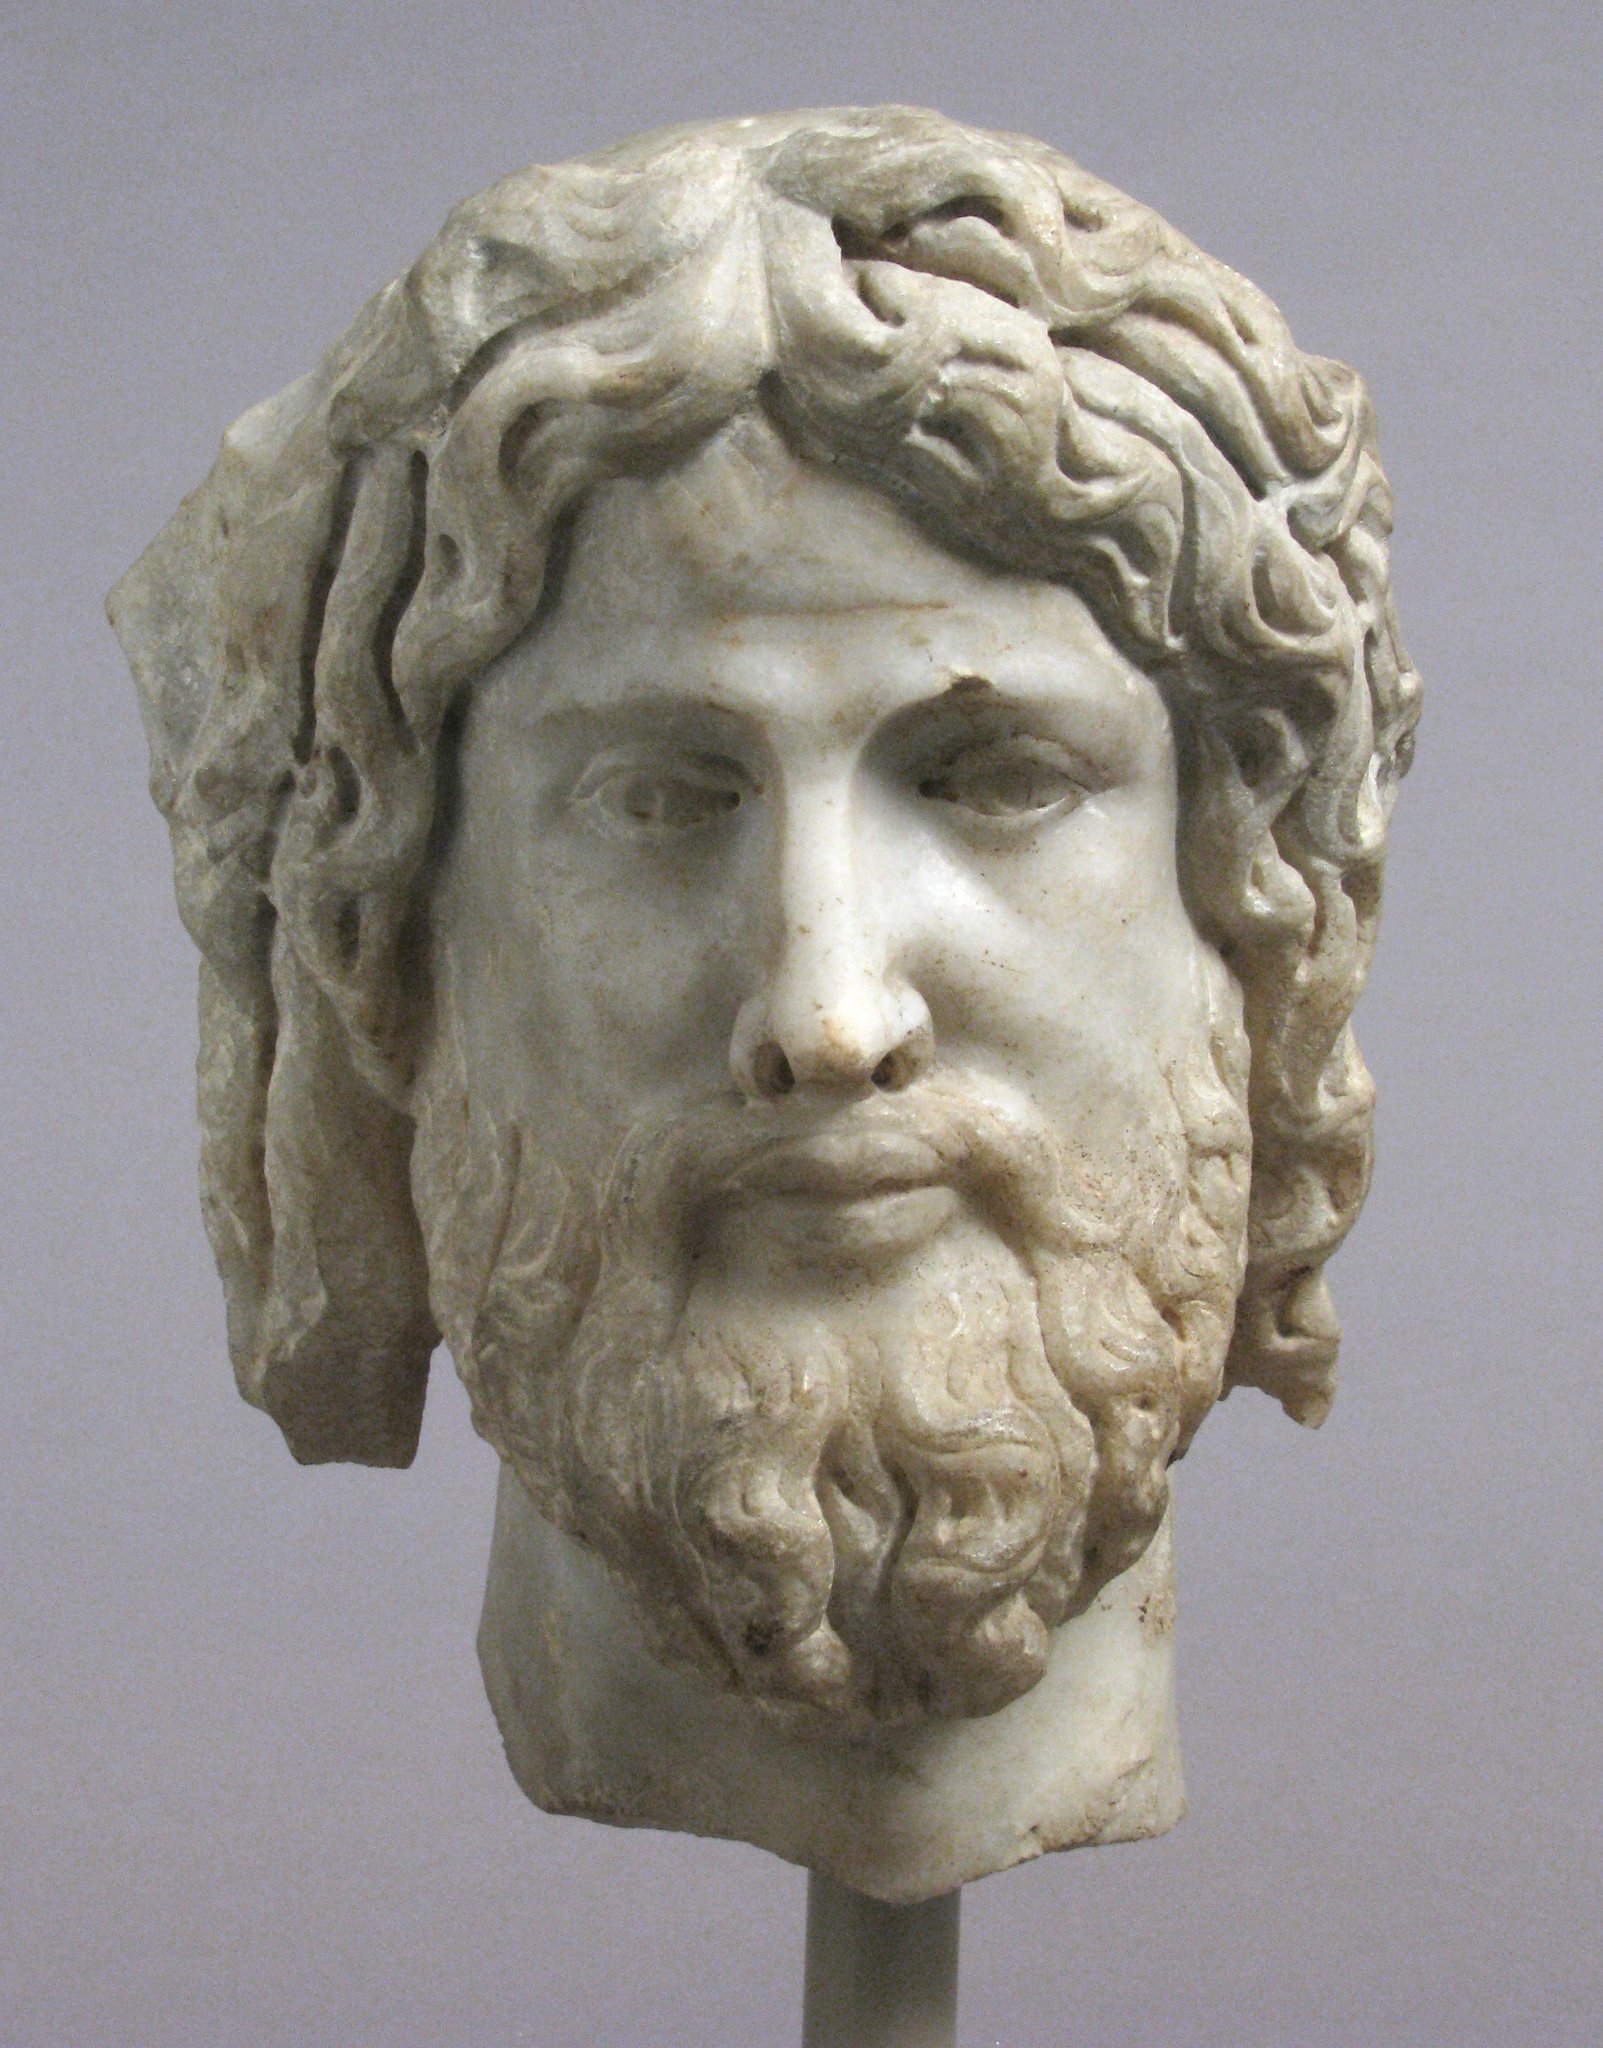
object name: statue head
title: Head of Christ or Zeus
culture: roman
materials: marble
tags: zeus,christ